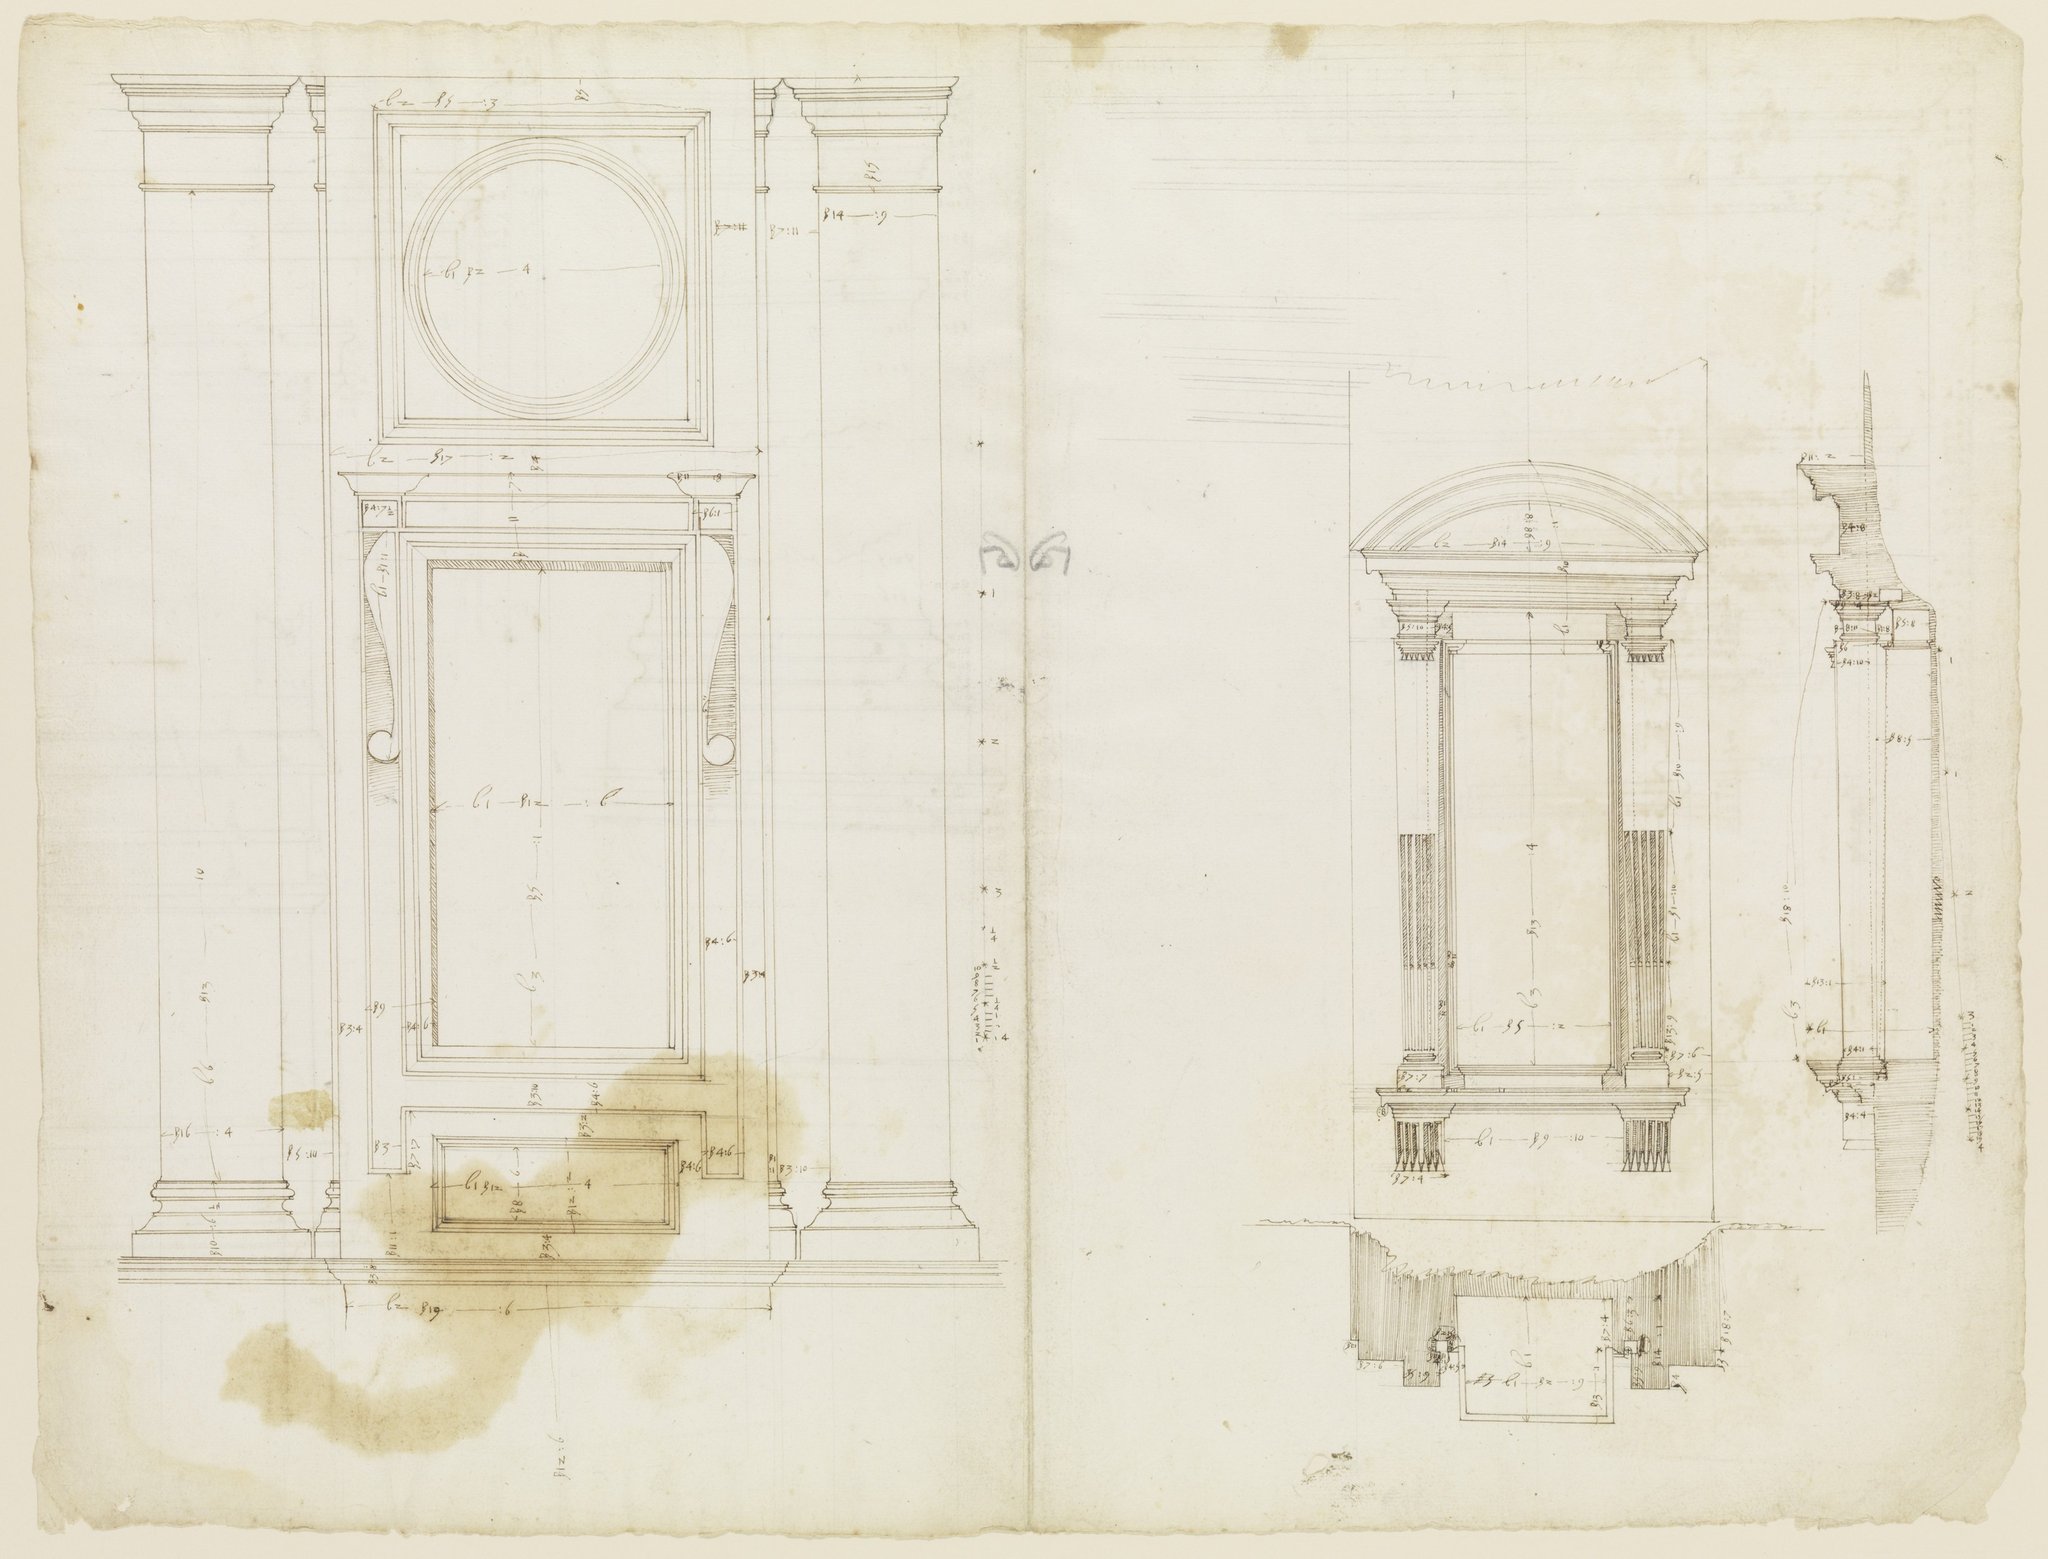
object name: drawing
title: San Lorenzo, Library, Ricetto, upper window, elevation; niche,elevation, plan, and section (recto) San Lorenzo, Library, Ricetto, niche, details; upper window, details, elevation (verso)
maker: anonymous, french, 16th century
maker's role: draftsman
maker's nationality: french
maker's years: 1500-1600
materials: chalk, ink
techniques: incising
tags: architecture